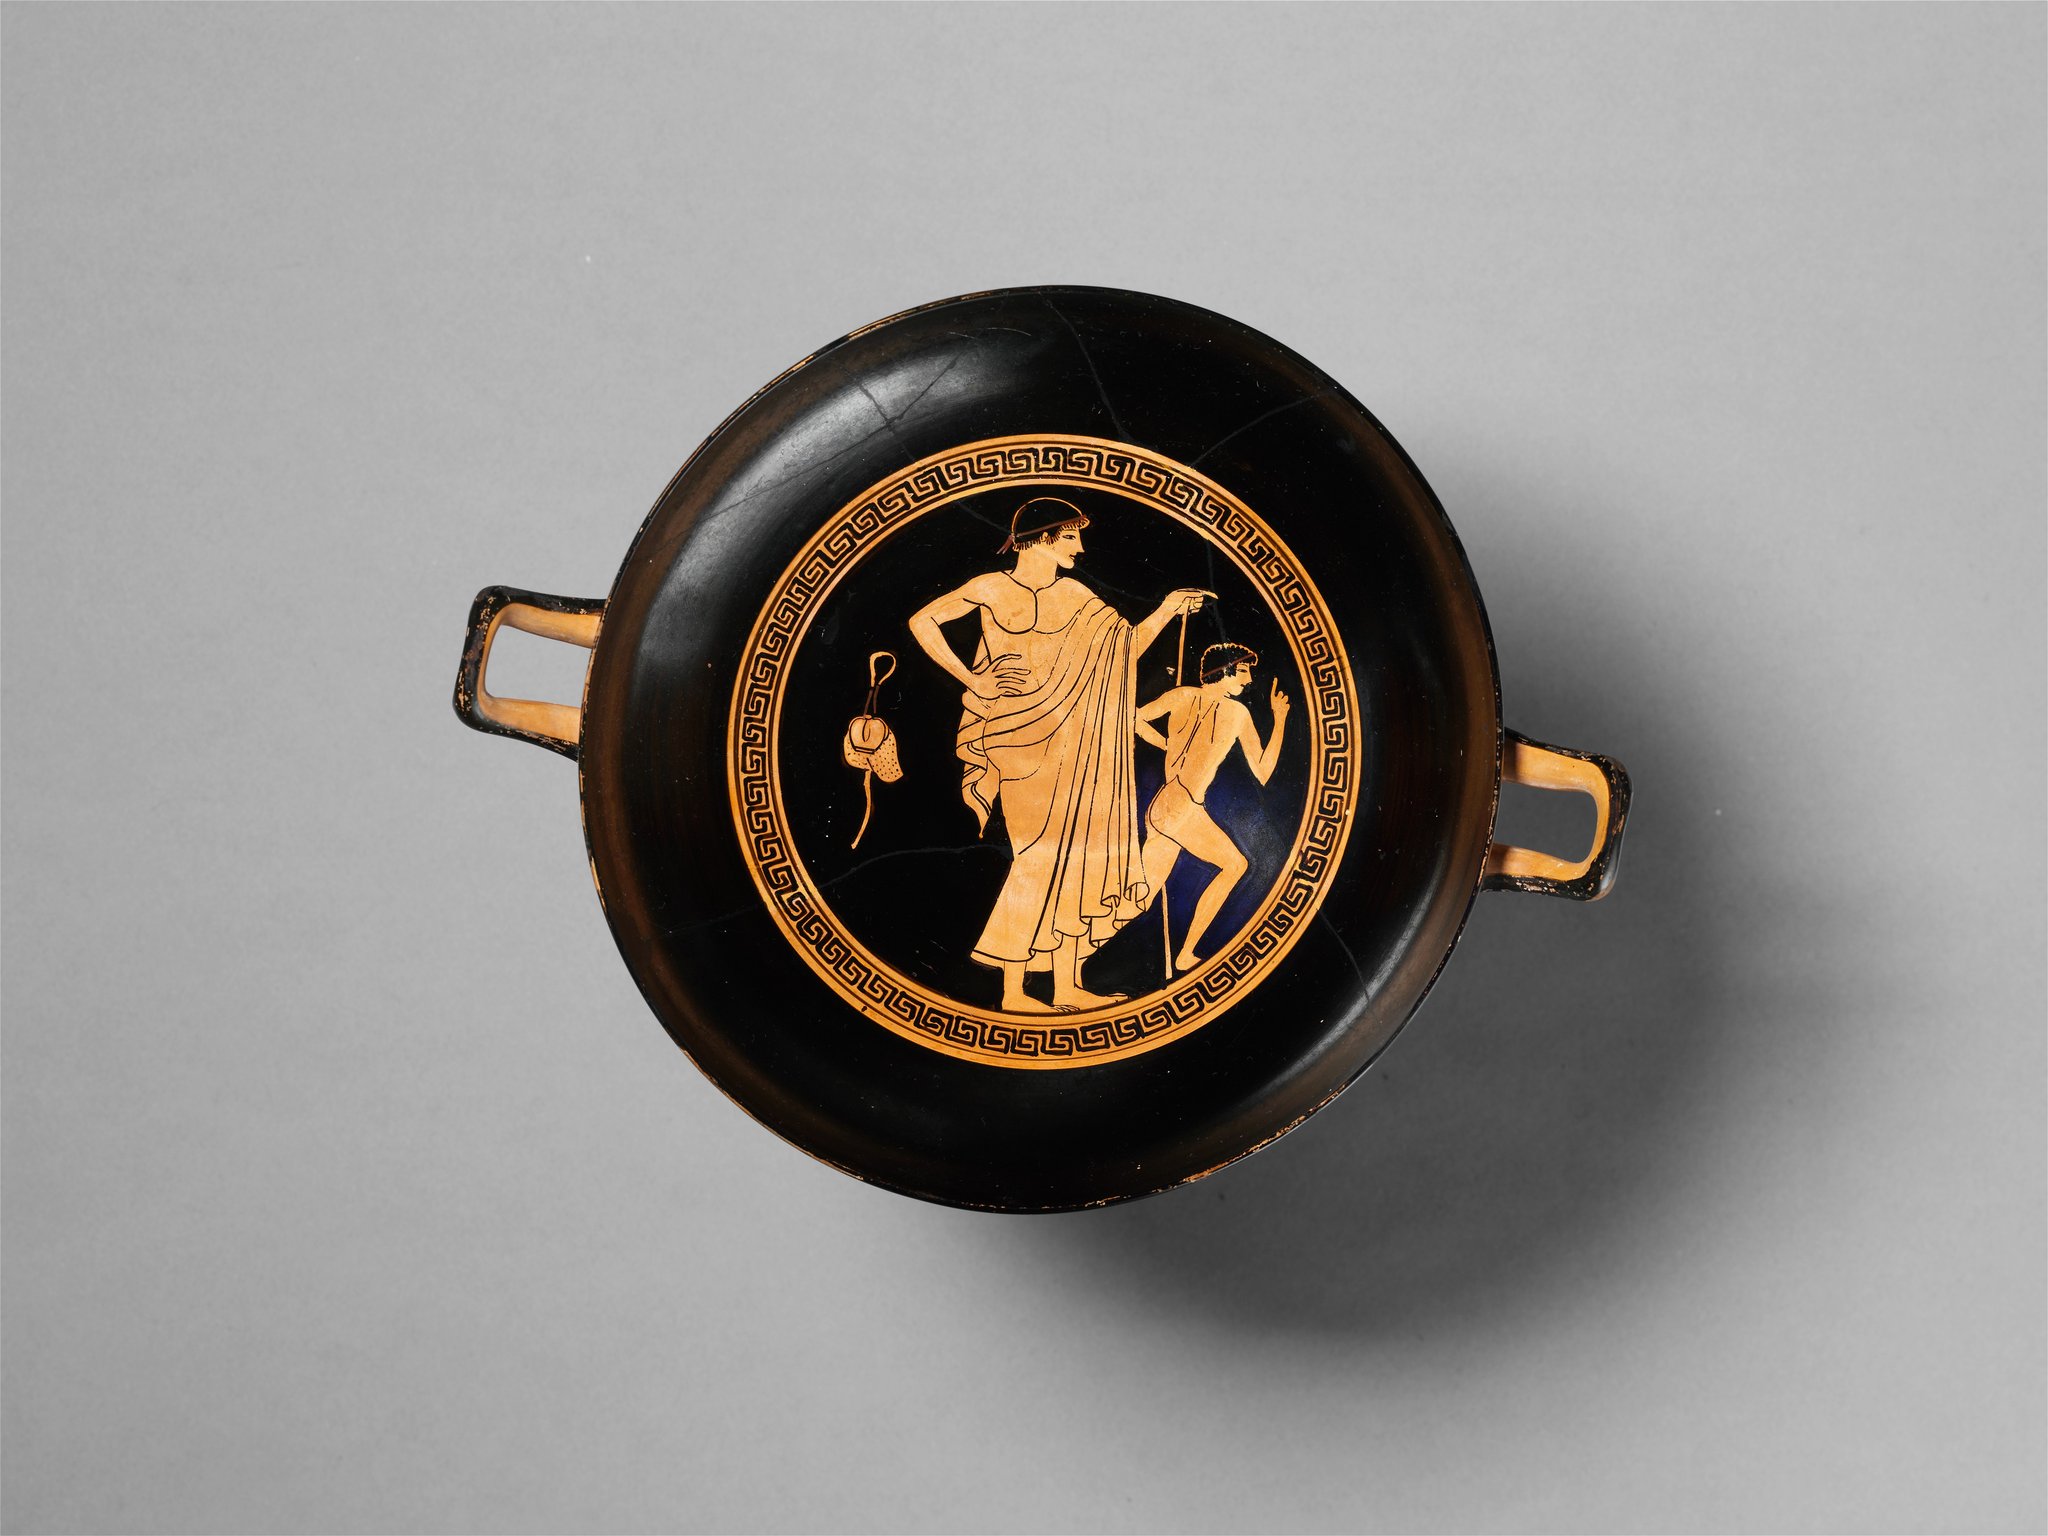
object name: kylix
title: Terracotta kylix (drinking cup)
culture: greek, attic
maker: painter of new york gr 576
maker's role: artist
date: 480 BCE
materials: terracotta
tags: boys,men